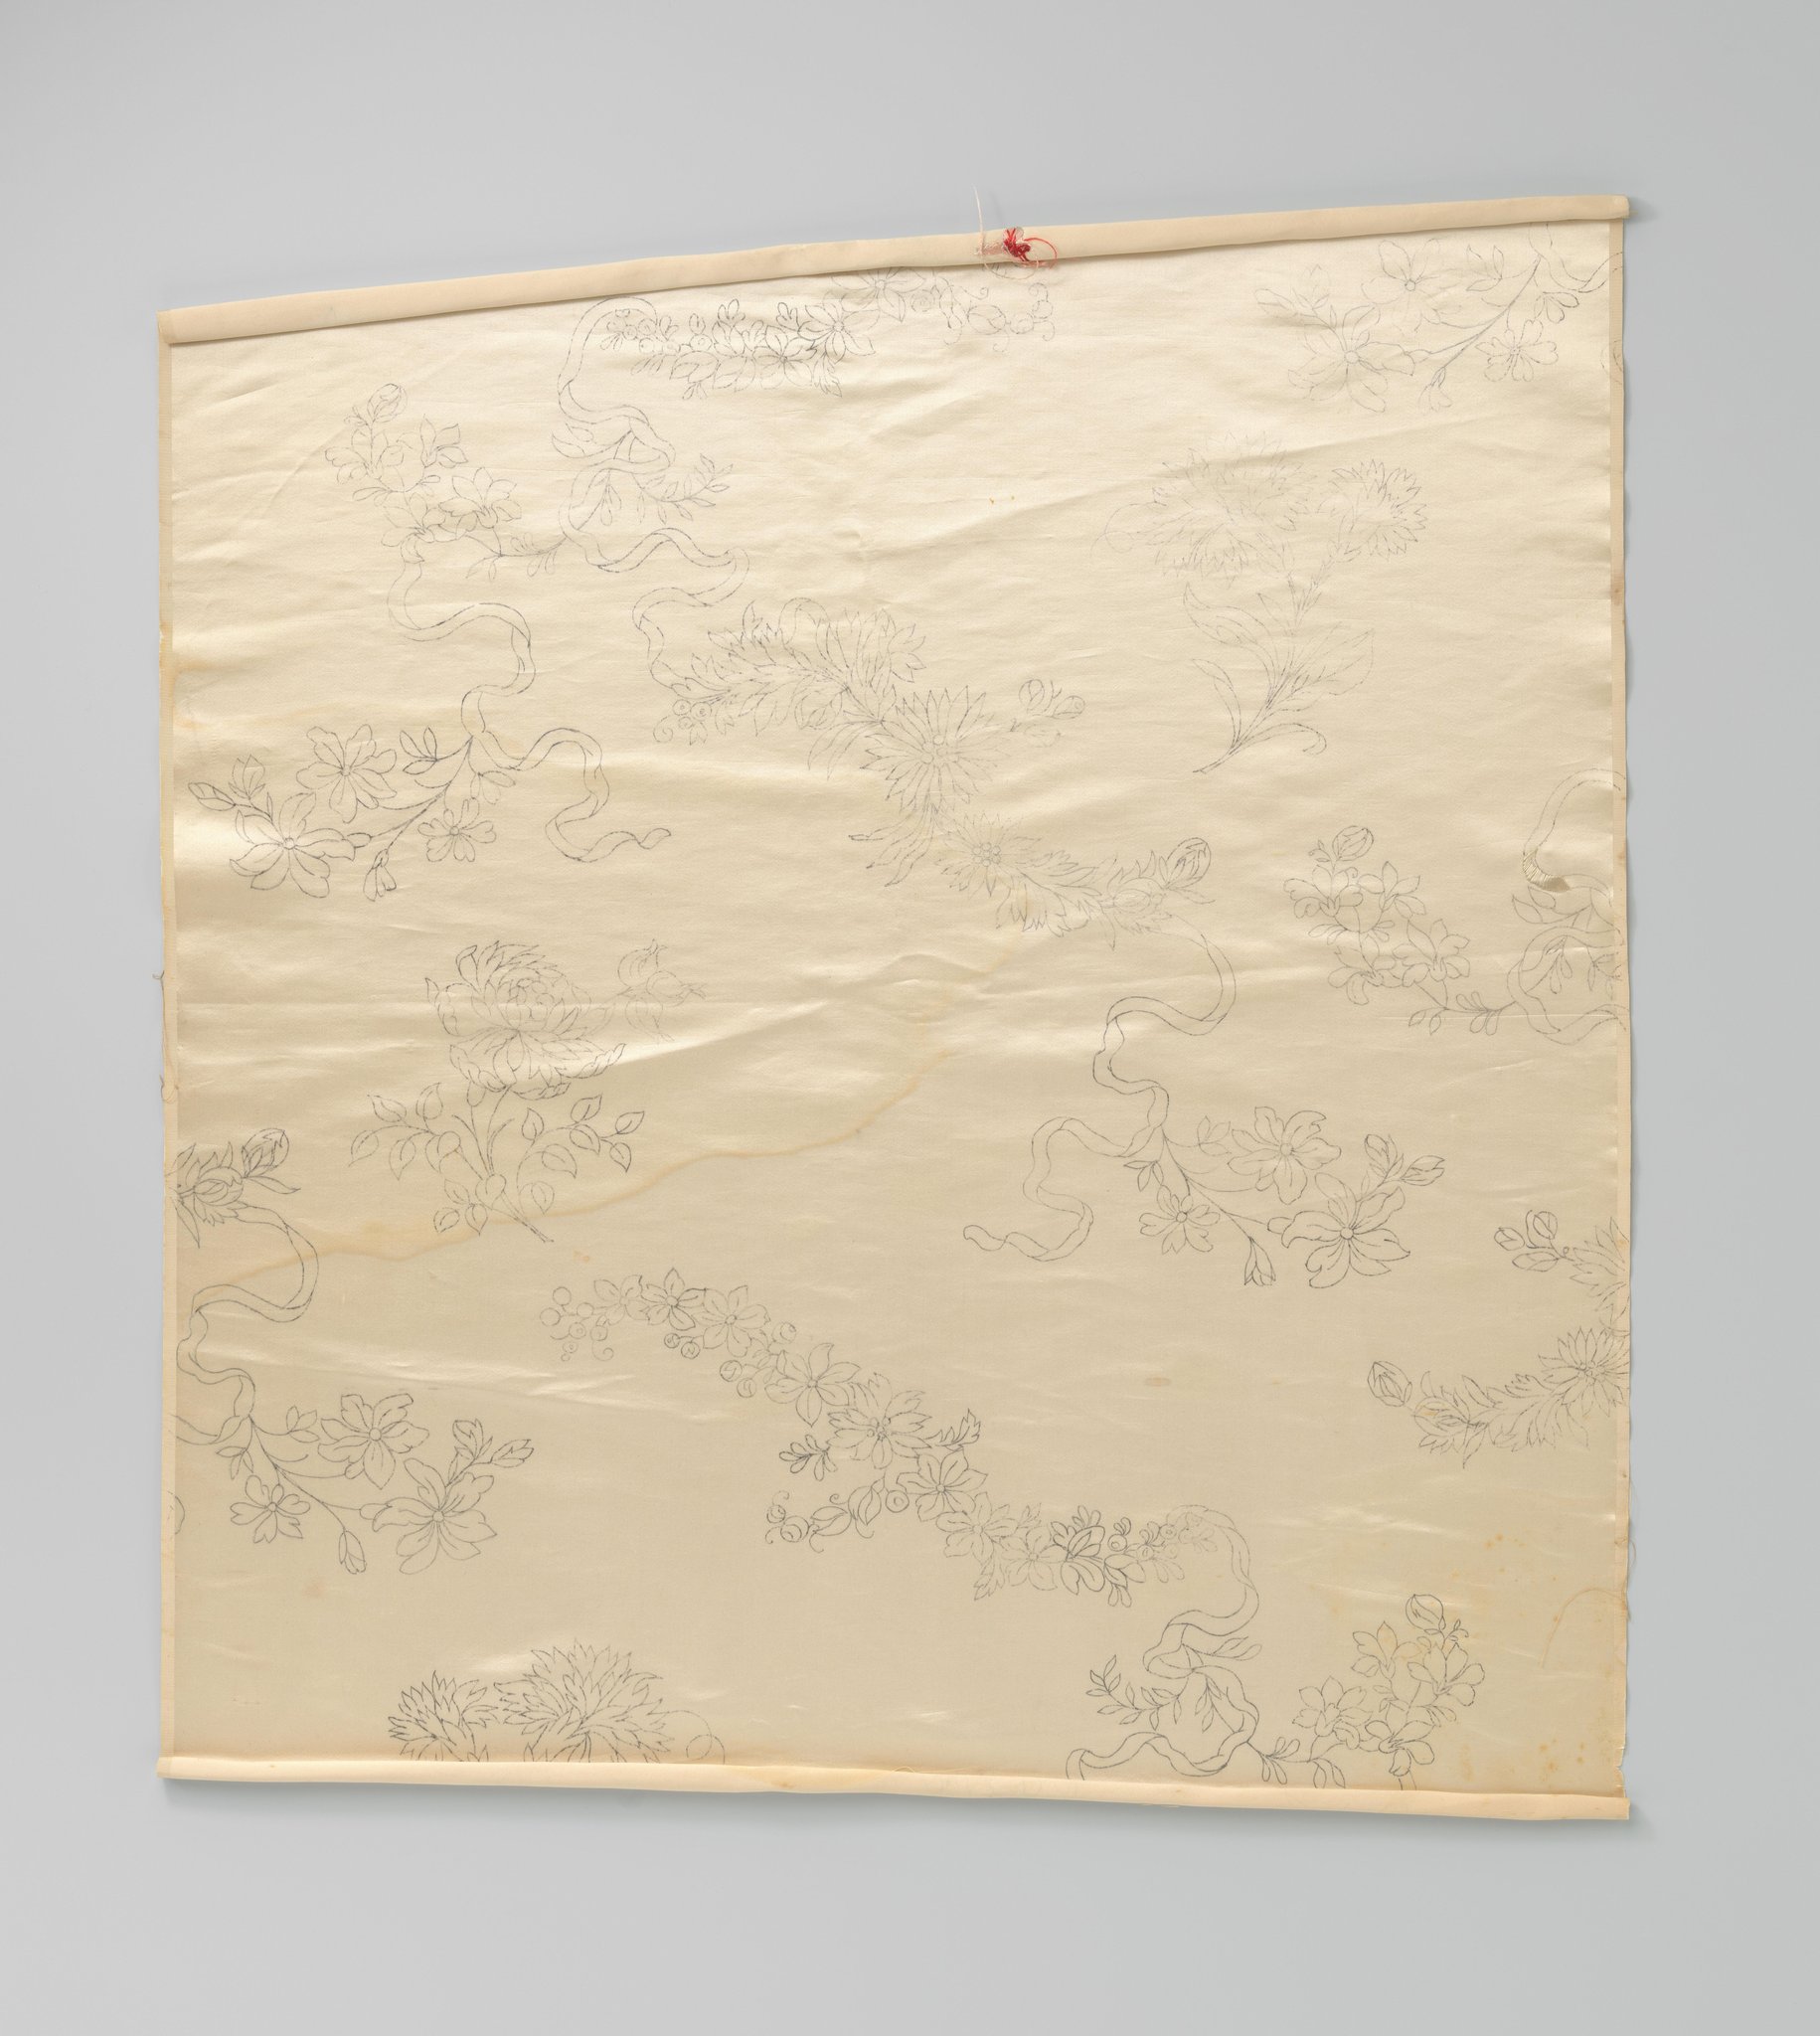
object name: metrage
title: Metrage witte satijn met voorgetekend borduurpatroon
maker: Anonymous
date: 1750-1770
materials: silk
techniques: embroidered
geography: france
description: Metrage witte satijn met voorgetekend borduurpatroon. Tekening: slechts in omtreklijnen uitgevoerd staat een lopend patroon met een schuin over geschikt, grillig slingerend lint, waar middenop een chrysantentak staat en losse bloesemtakken als zijtak, en aan het uiteinde, terwijl een gesloten rij van bloempjes aan het andere eind zit. Hetzelfde patroon, maar dan omgedraaid, volgt daar op. In de bocht na het lint staat een losse anjer, en daartussenin een andere bloem. Borduurwerk. Slechts één stukje lichtblauw is in het lint geborduurd, en in een pan bloemblaadjes rood en roze.